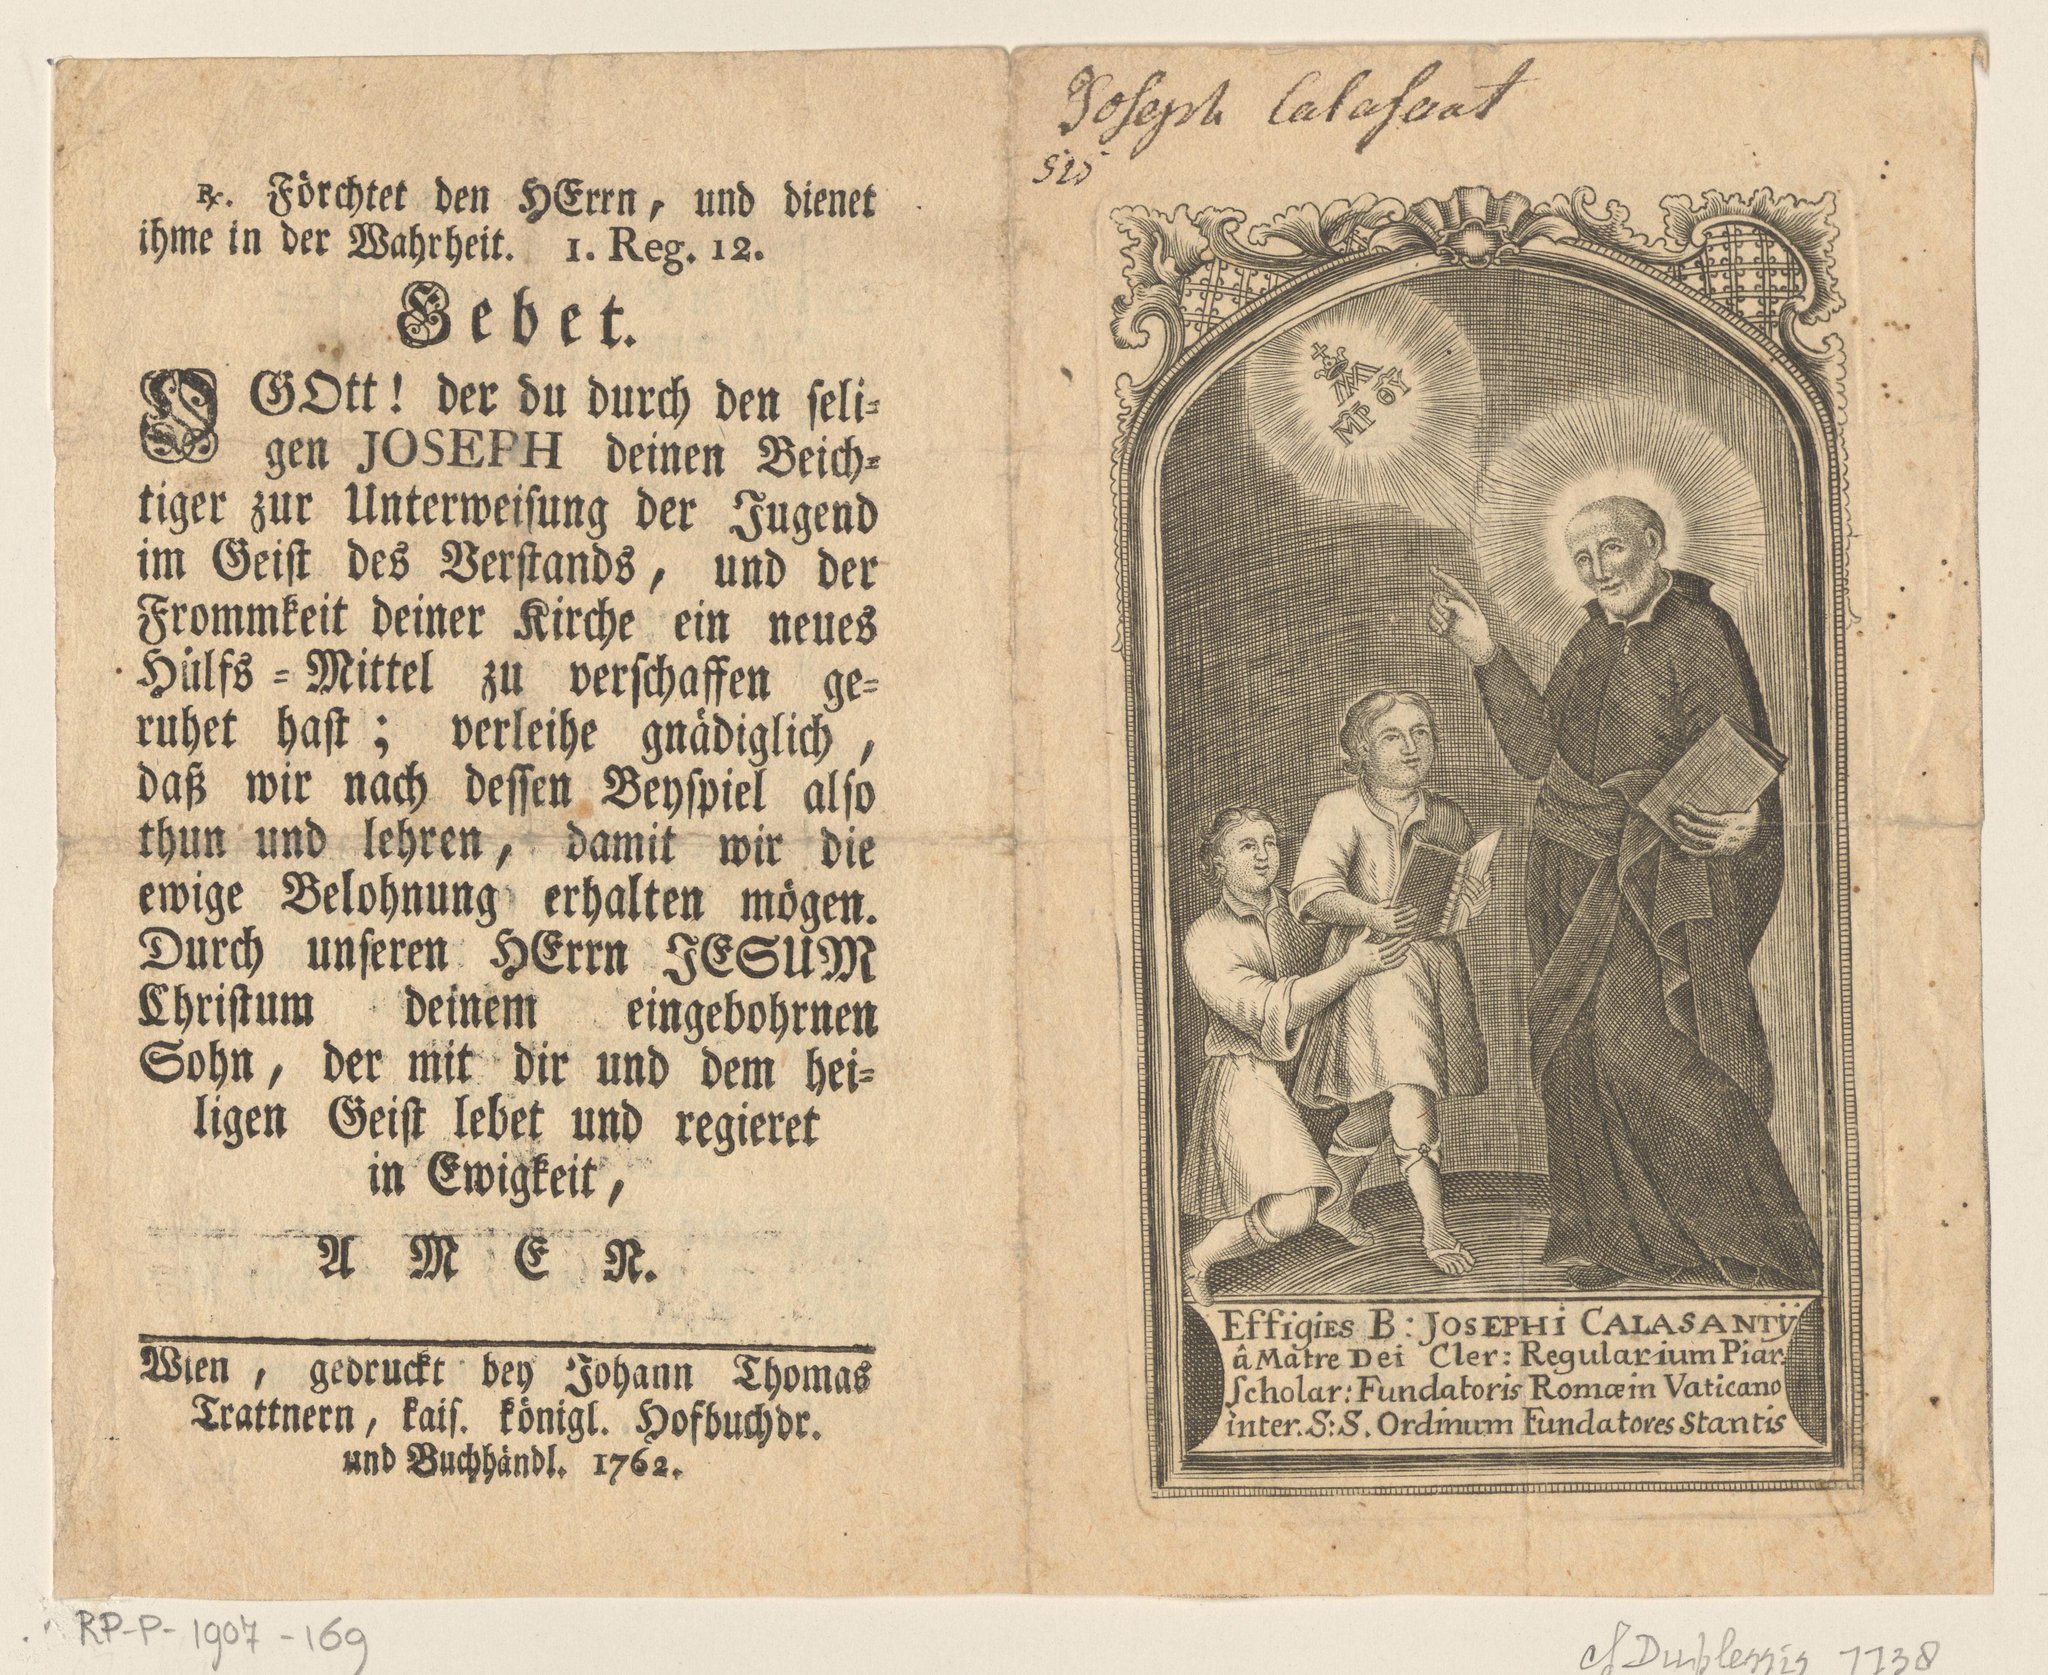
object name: print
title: Portret van Josephi B. Calasanctij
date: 1762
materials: paper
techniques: engraving, letterpress printing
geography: vienna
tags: historical persons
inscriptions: collector's mark: Lugt 2228